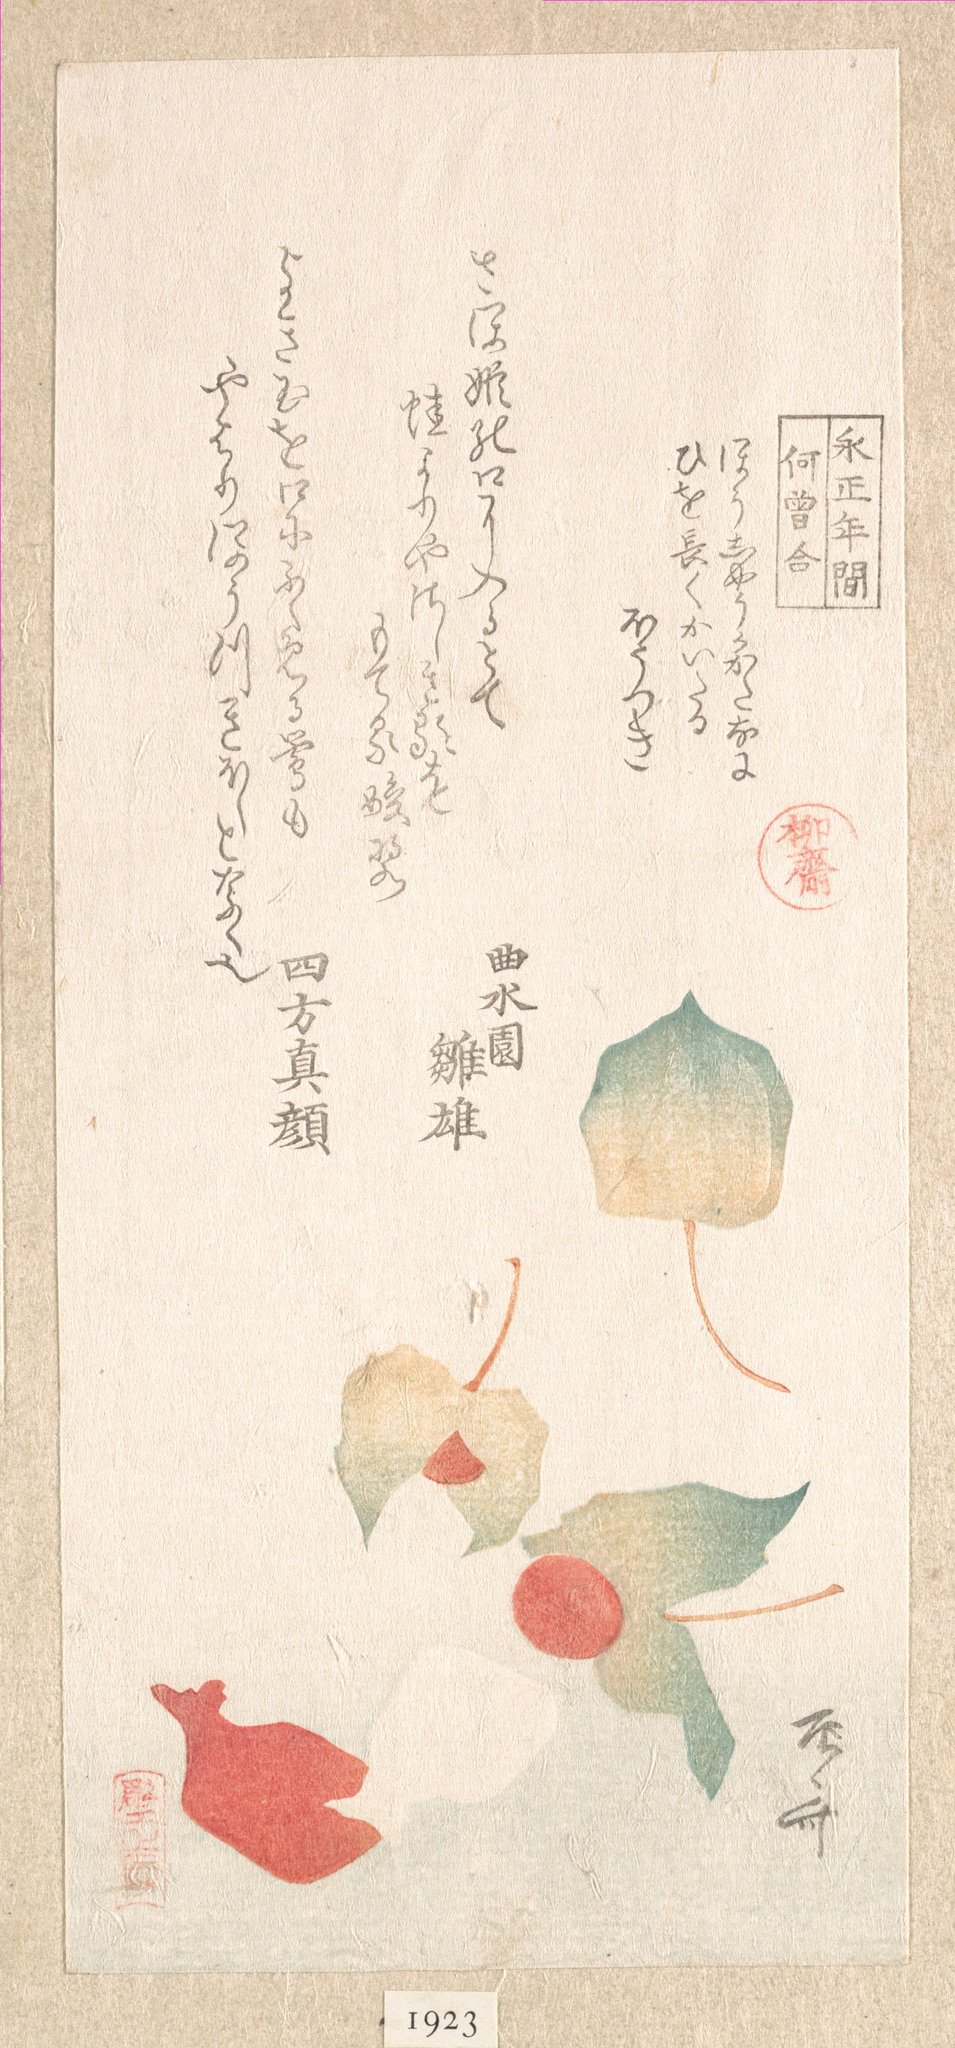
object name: print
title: Winter Cherries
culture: japanese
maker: ryūryūkyo shinsai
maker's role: artist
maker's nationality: japanese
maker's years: 1799-1823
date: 1799-1823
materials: ink, paper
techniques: surimono, woodblock print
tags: cherries,leaves